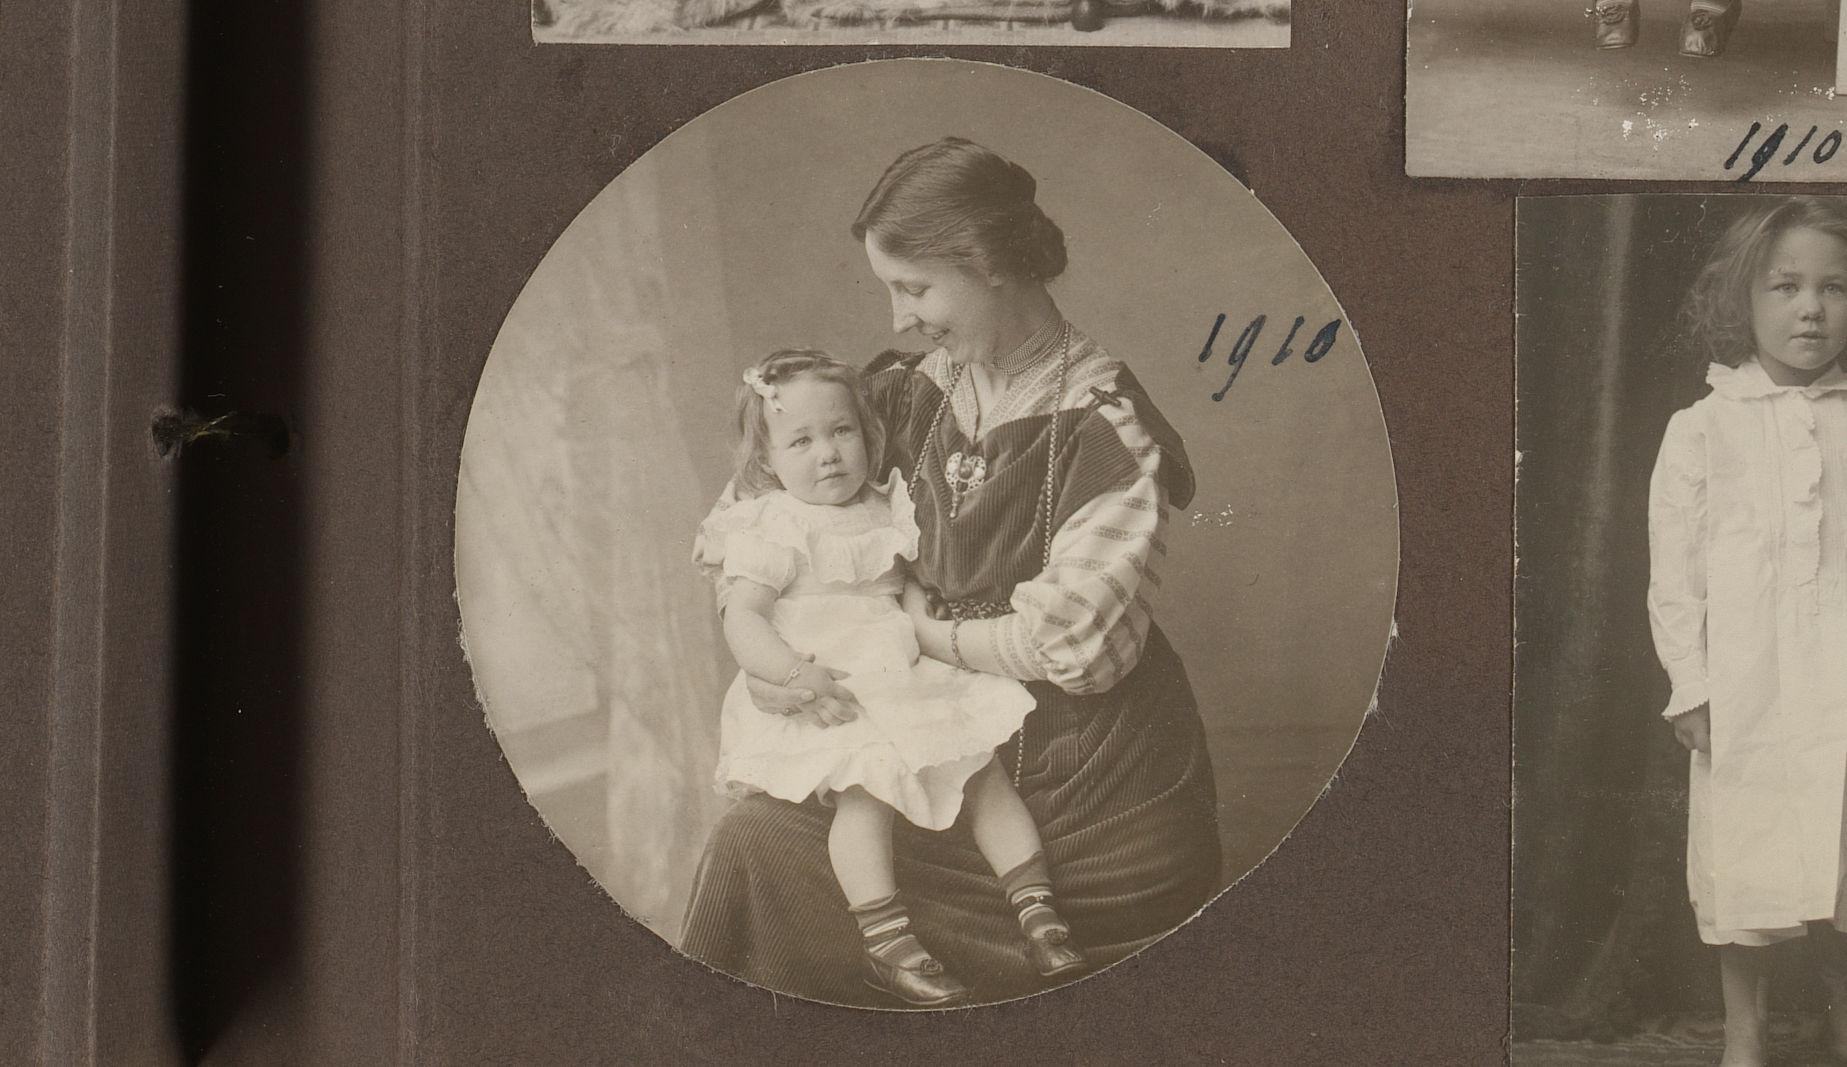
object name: photograph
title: Portret van Elsa Diepenbrock kijkend naar haar dochter Thea die op schoot zit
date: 1910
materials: paper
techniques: cutting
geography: netherlands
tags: amsterdam, jonkvrouw wilhelmina elisabeth petronella cornelia de jong van beek en donk, mother with daughter(s) (mother-love), historical persons - bb - woman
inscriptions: date: ‘1910’